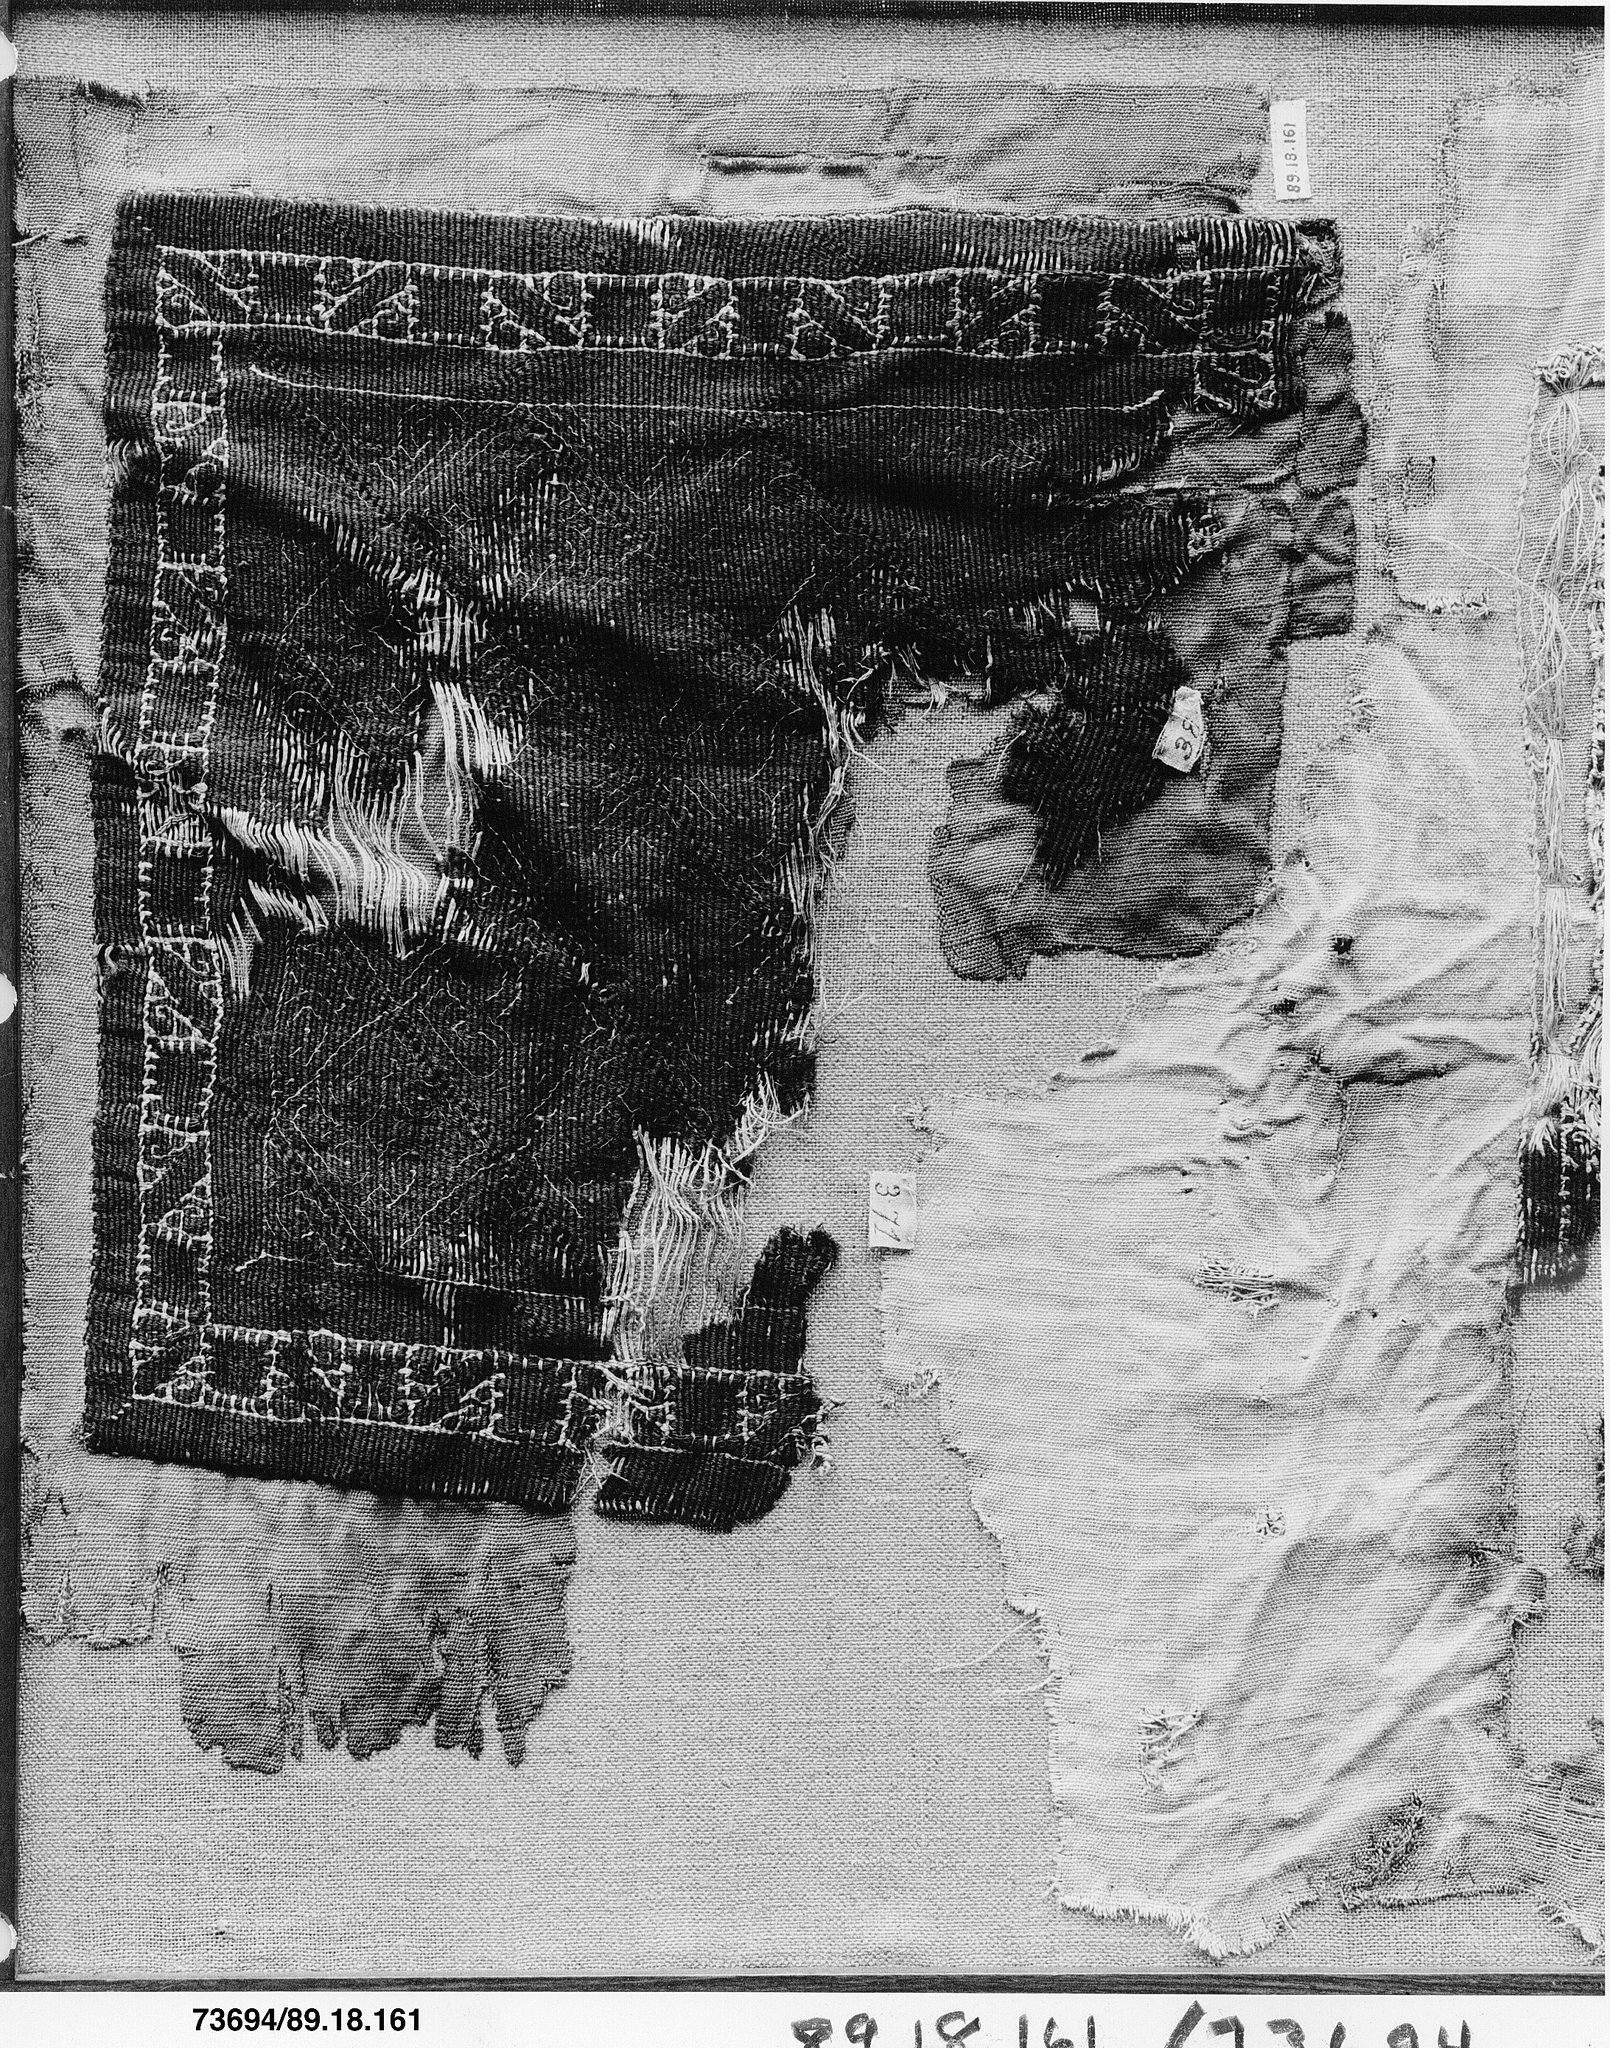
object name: textile fragment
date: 201-400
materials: linen, wool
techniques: weave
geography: egypt